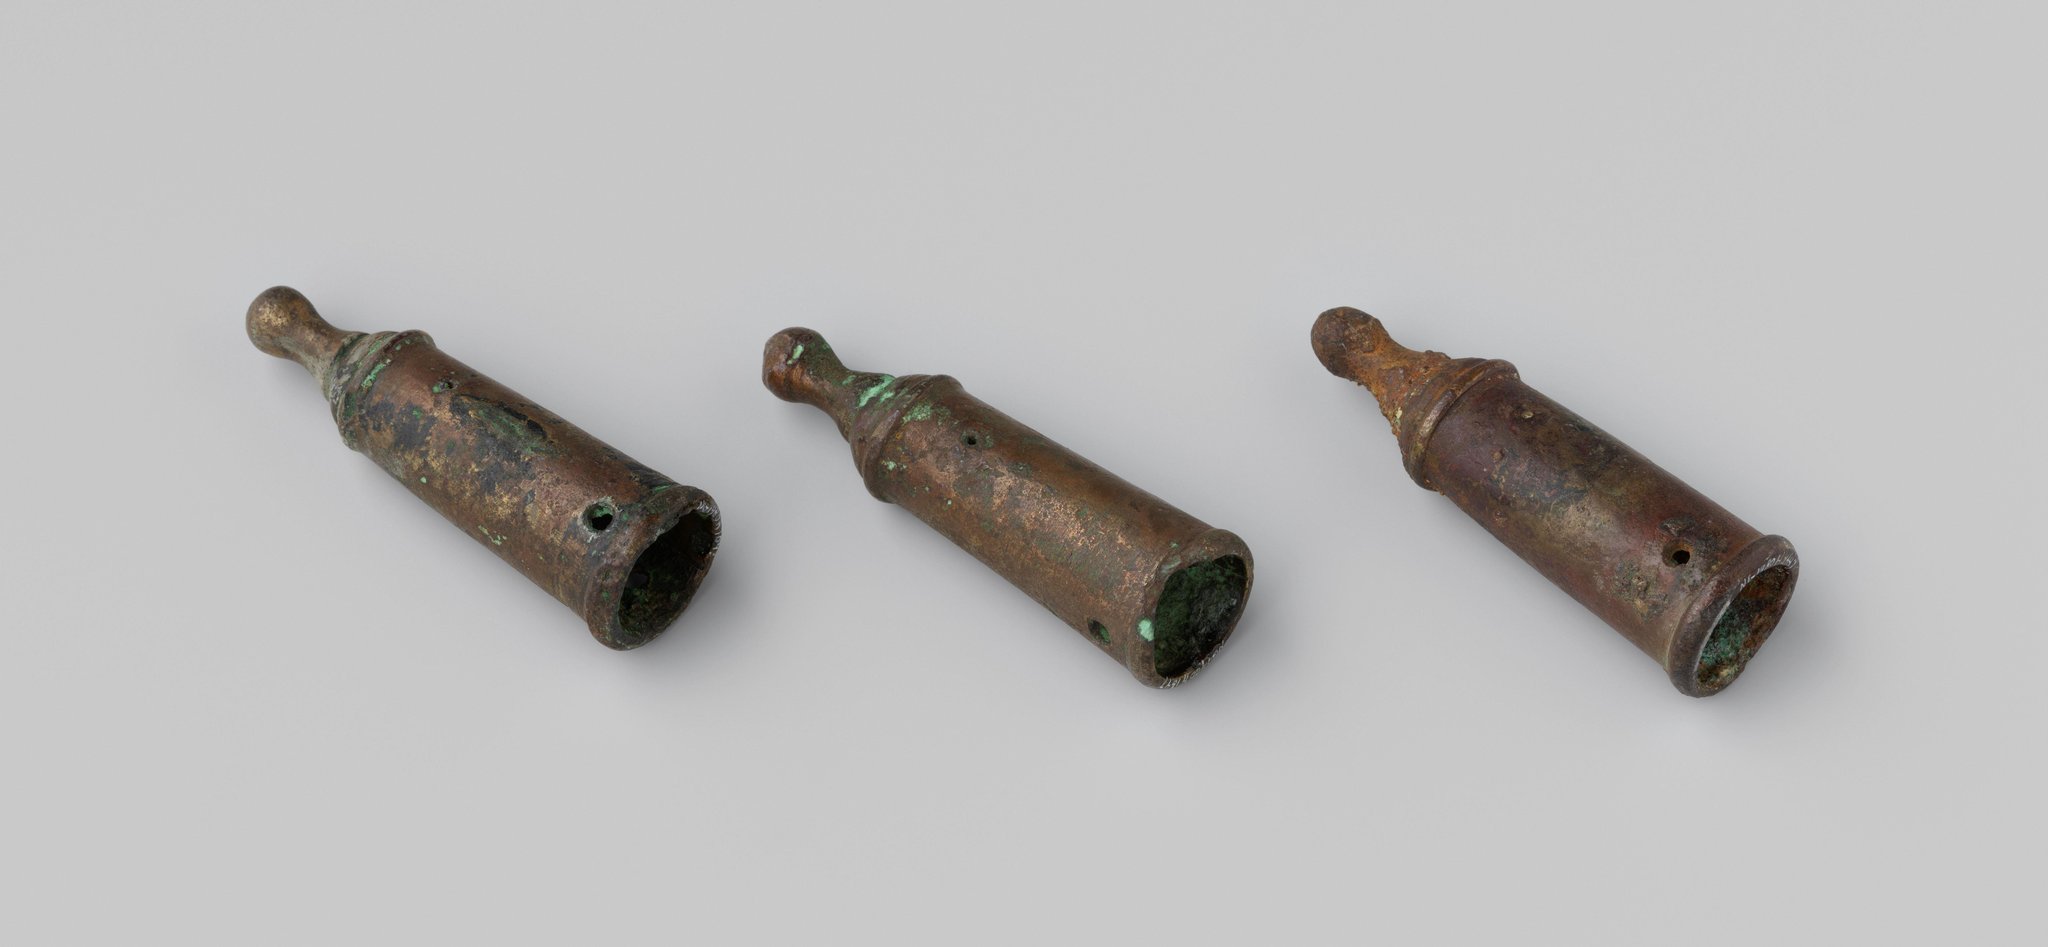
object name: clamp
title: Klemmen afkomstig uit het wrak van de Oost-Indiëvaarder Hollandia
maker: Anonymous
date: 1700-1743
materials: copper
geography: netherlands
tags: verenigde oostindische compagnie, hollandia (schip)